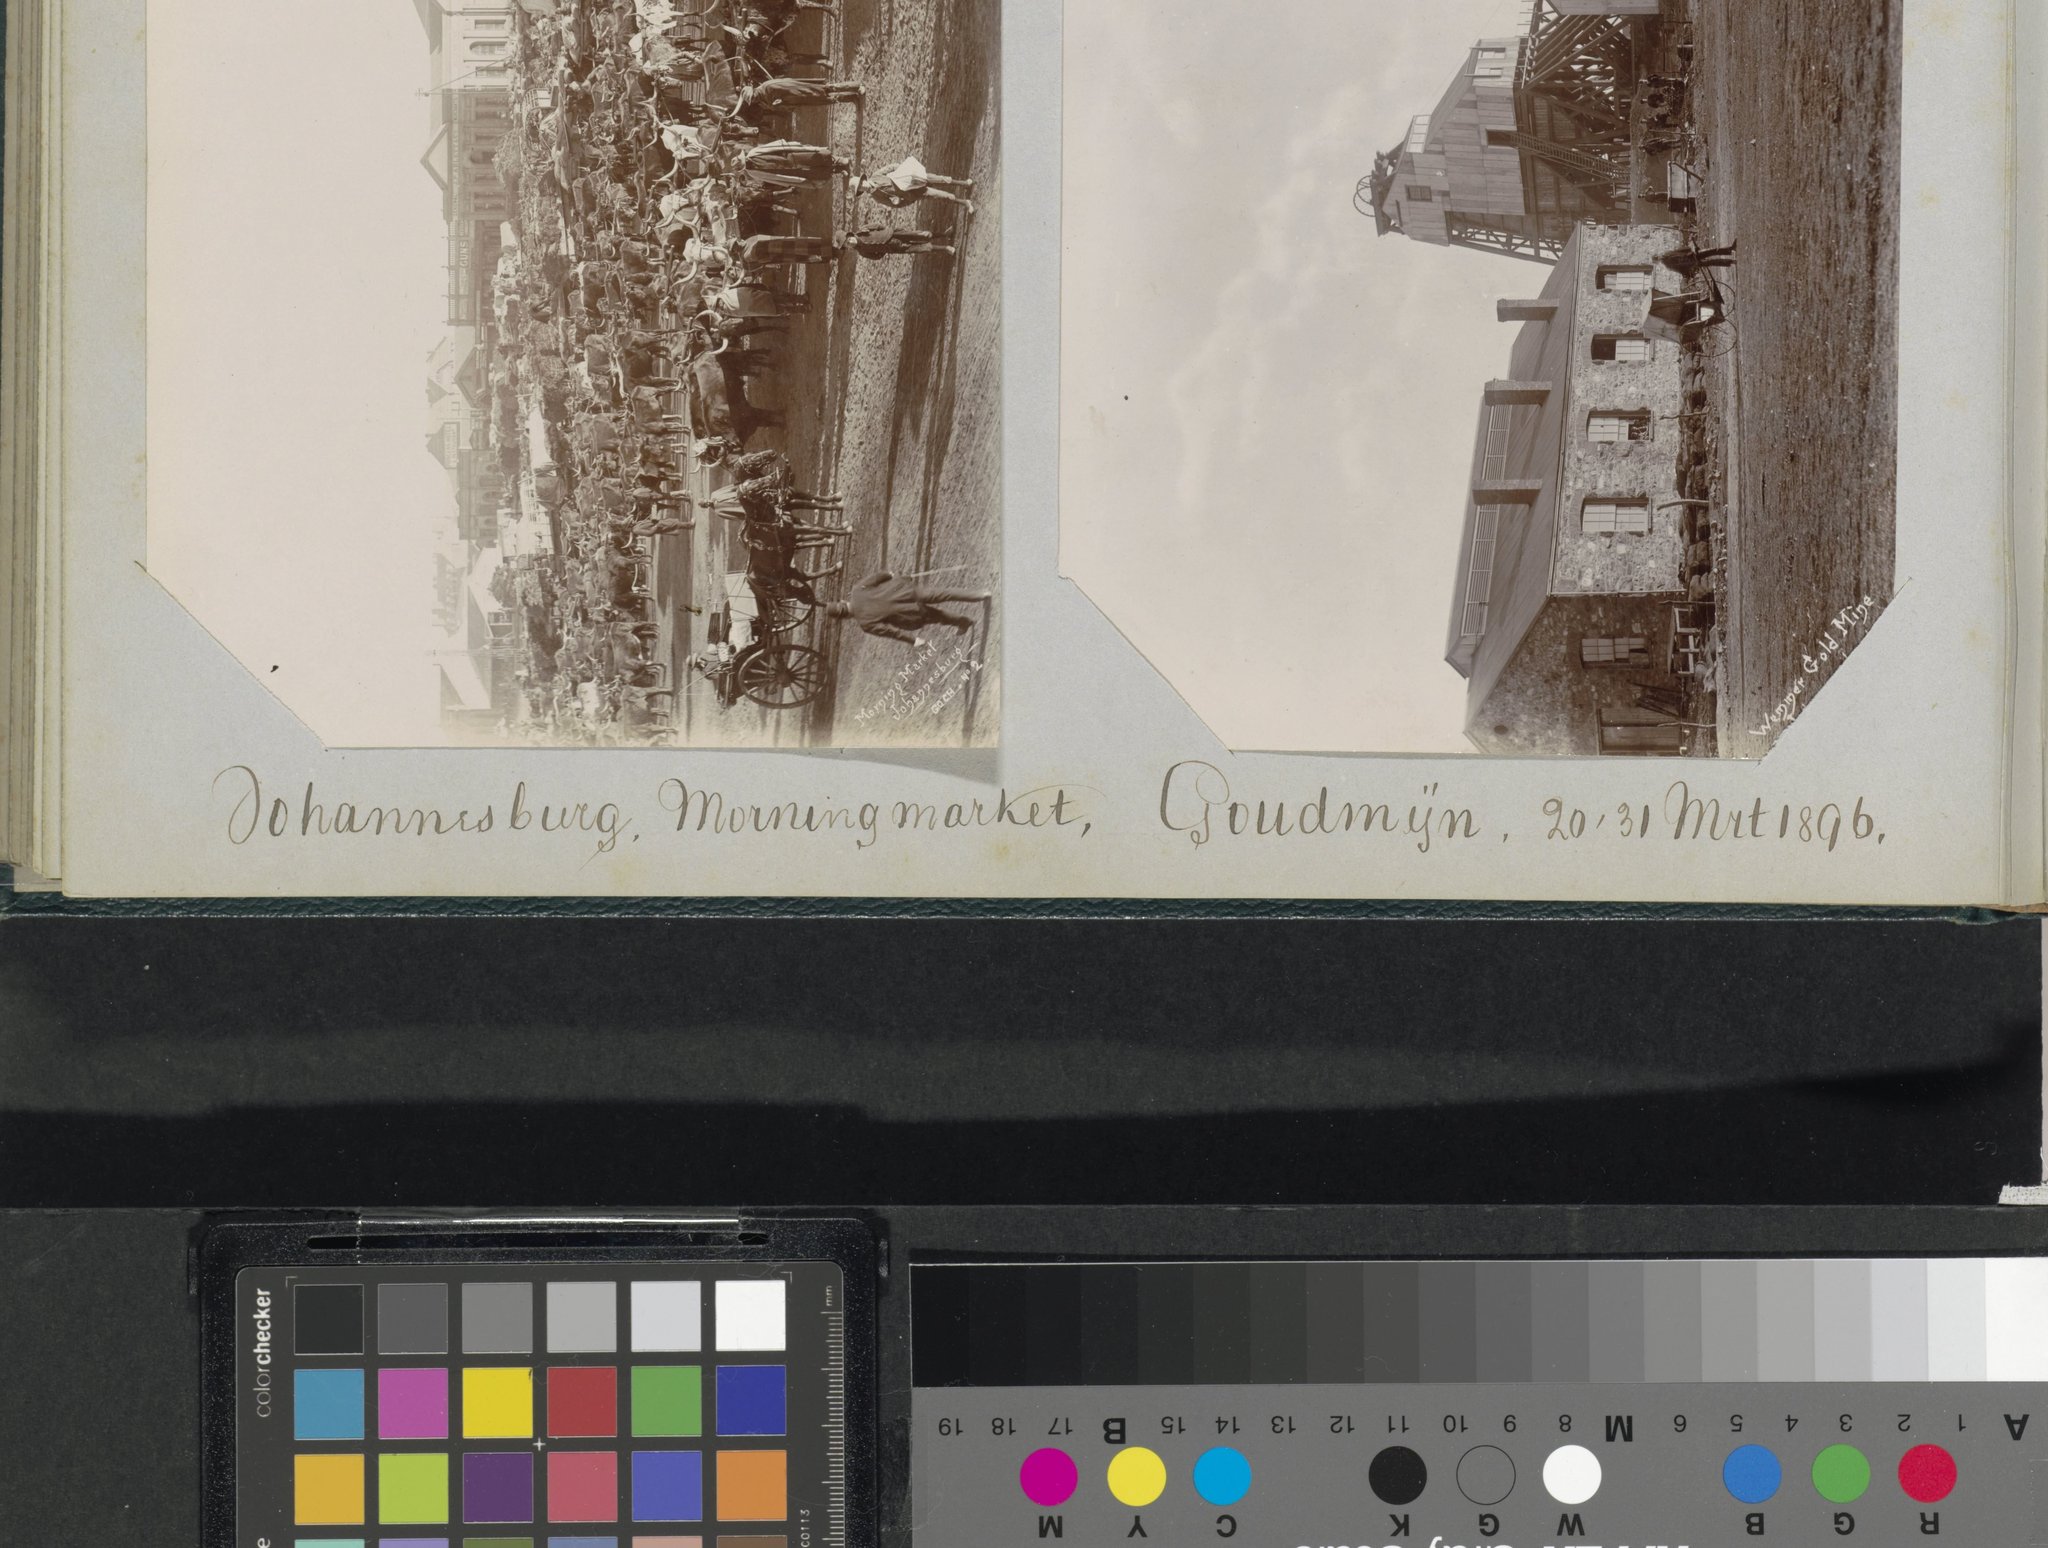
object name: photograph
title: Marktplein met ossen en karren te Johannesburg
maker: james f. goch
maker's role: fotograaf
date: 1896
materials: photographic support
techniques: gelatin silver print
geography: johannesburg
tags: market, square, place, circus, etc. (+ city(-scape) with figures, staffage), johannesburg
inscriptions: annotation: ‘Johannesburg, Morning market, Goudmijn, 20-31 mrt 1896’, inscription: ‘Morning Market/ Johannesburg/ Goch No.2’